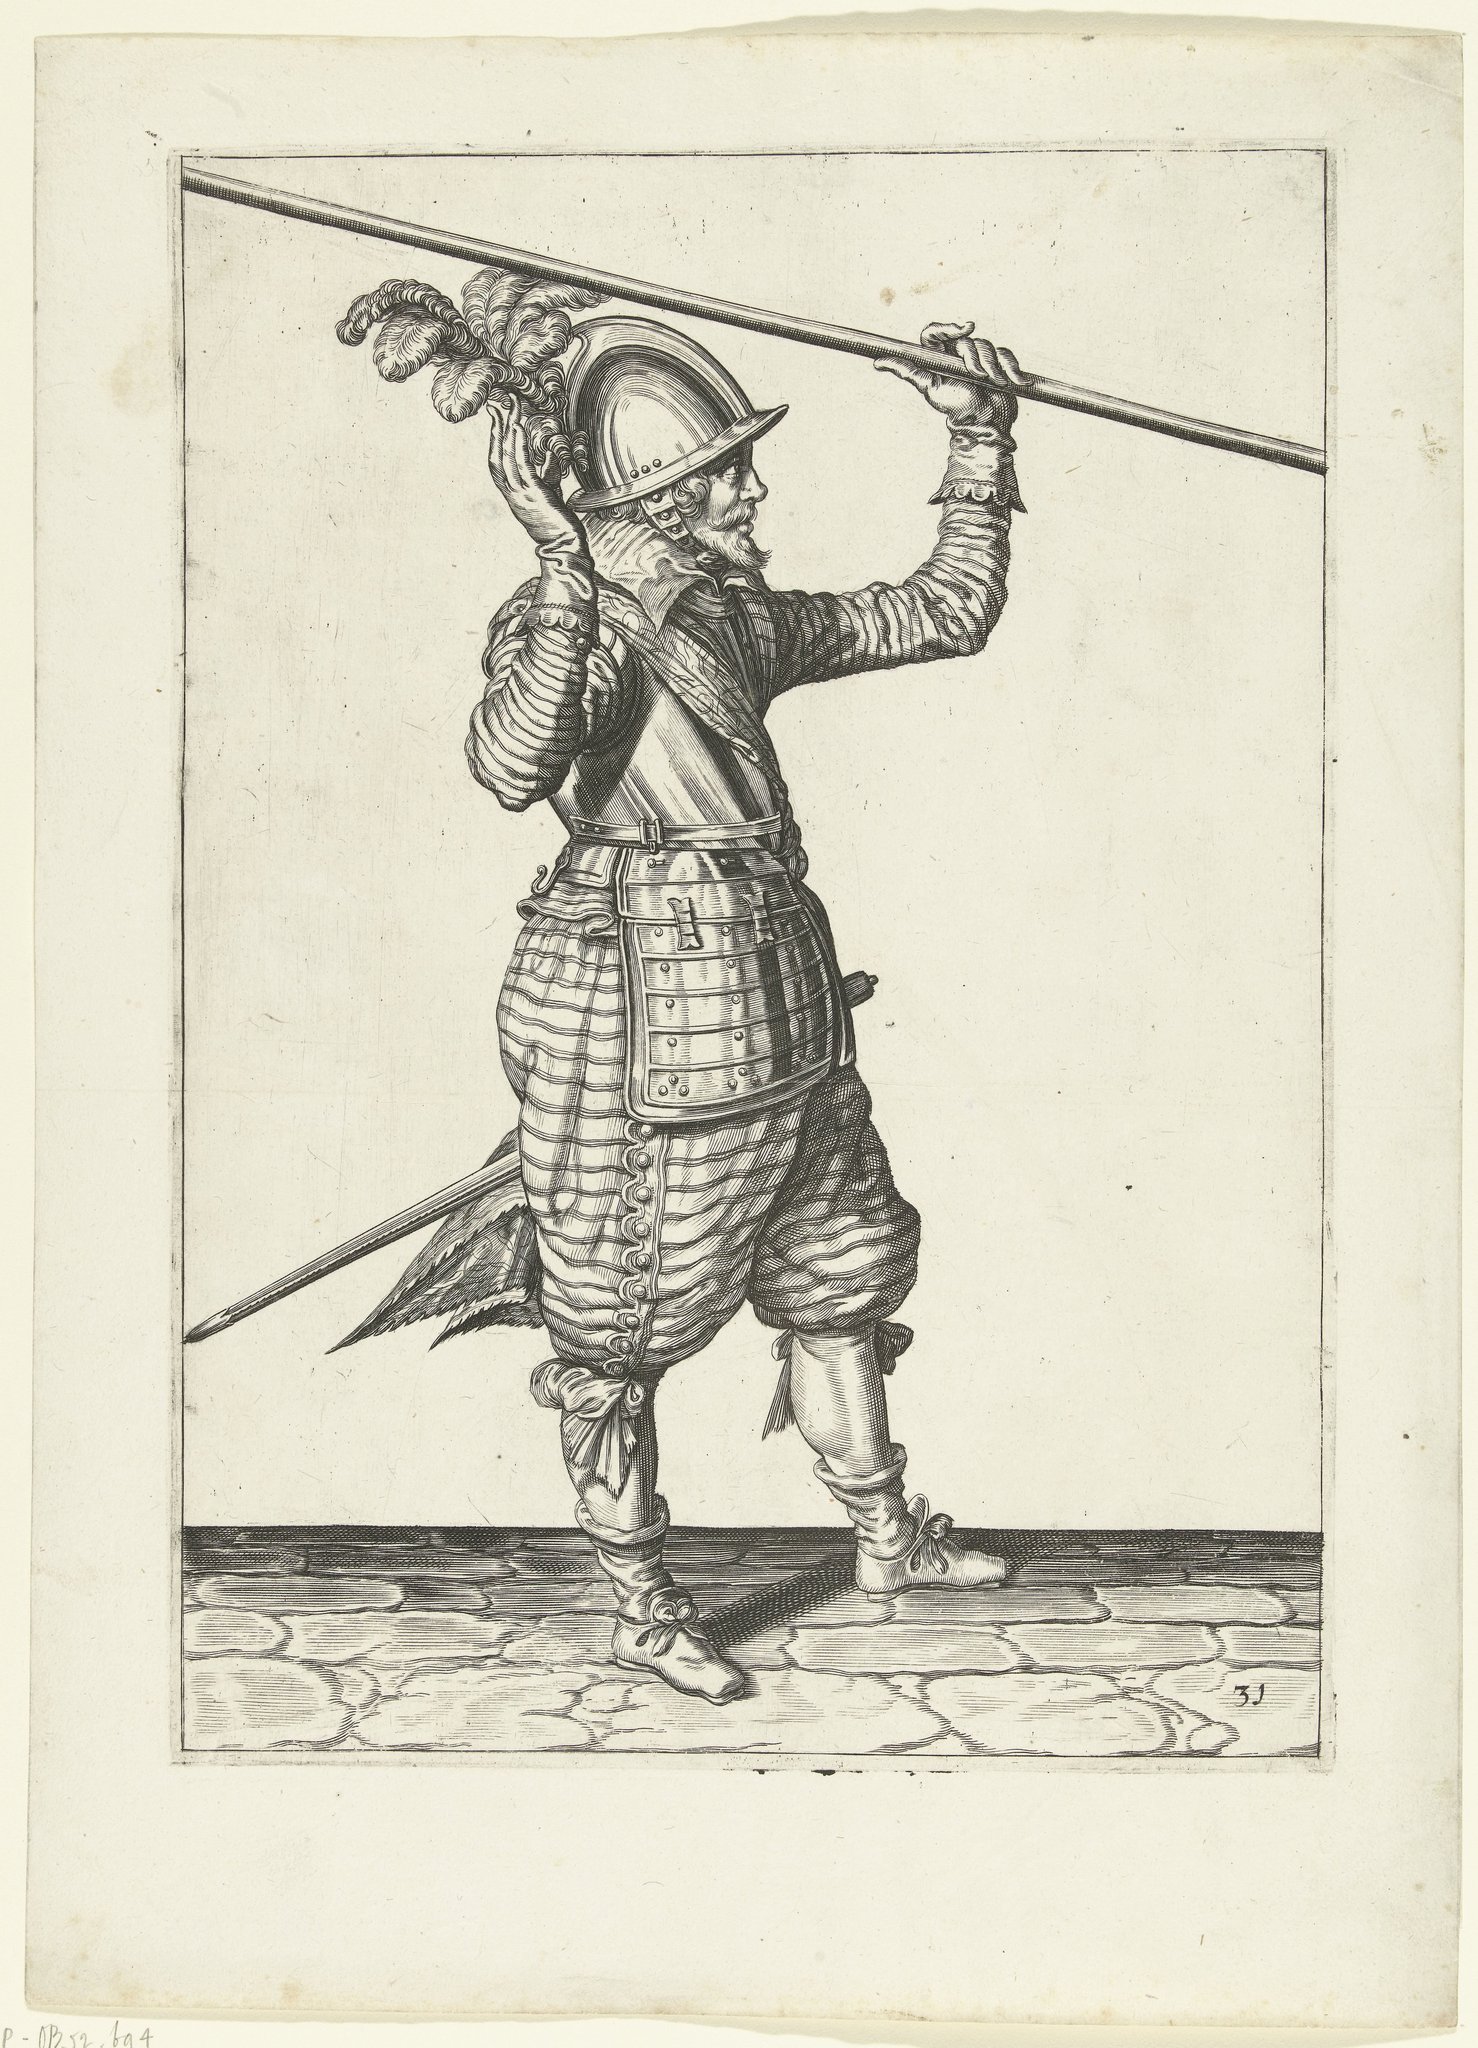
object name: print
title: Soldaat die zijn spies met zijn linkerhand boven zijn linkerschouder tilt, zijn rechterhand opgeheven om hem over te nemen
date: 1597-1607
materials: paper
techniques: engraving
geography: netherlands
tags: manoeuvre ~ military training, warfare; military affairs (+ mercenary troops, e.g.: lansquenets), helved weapons, polearms (for striking, hacking, thrusting): lance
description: Een soldaat, ten voeten uit, naar rechts, die een spies (lans) met zijn linkerhand boven zijn linkerschouder tilt, zijn rechterhand opgeheven om hem over te nemen. Deze prent is onderdeel van de reeks van 32 genummerde prenten van spiesdragers uit de Wapenhandelinghe.